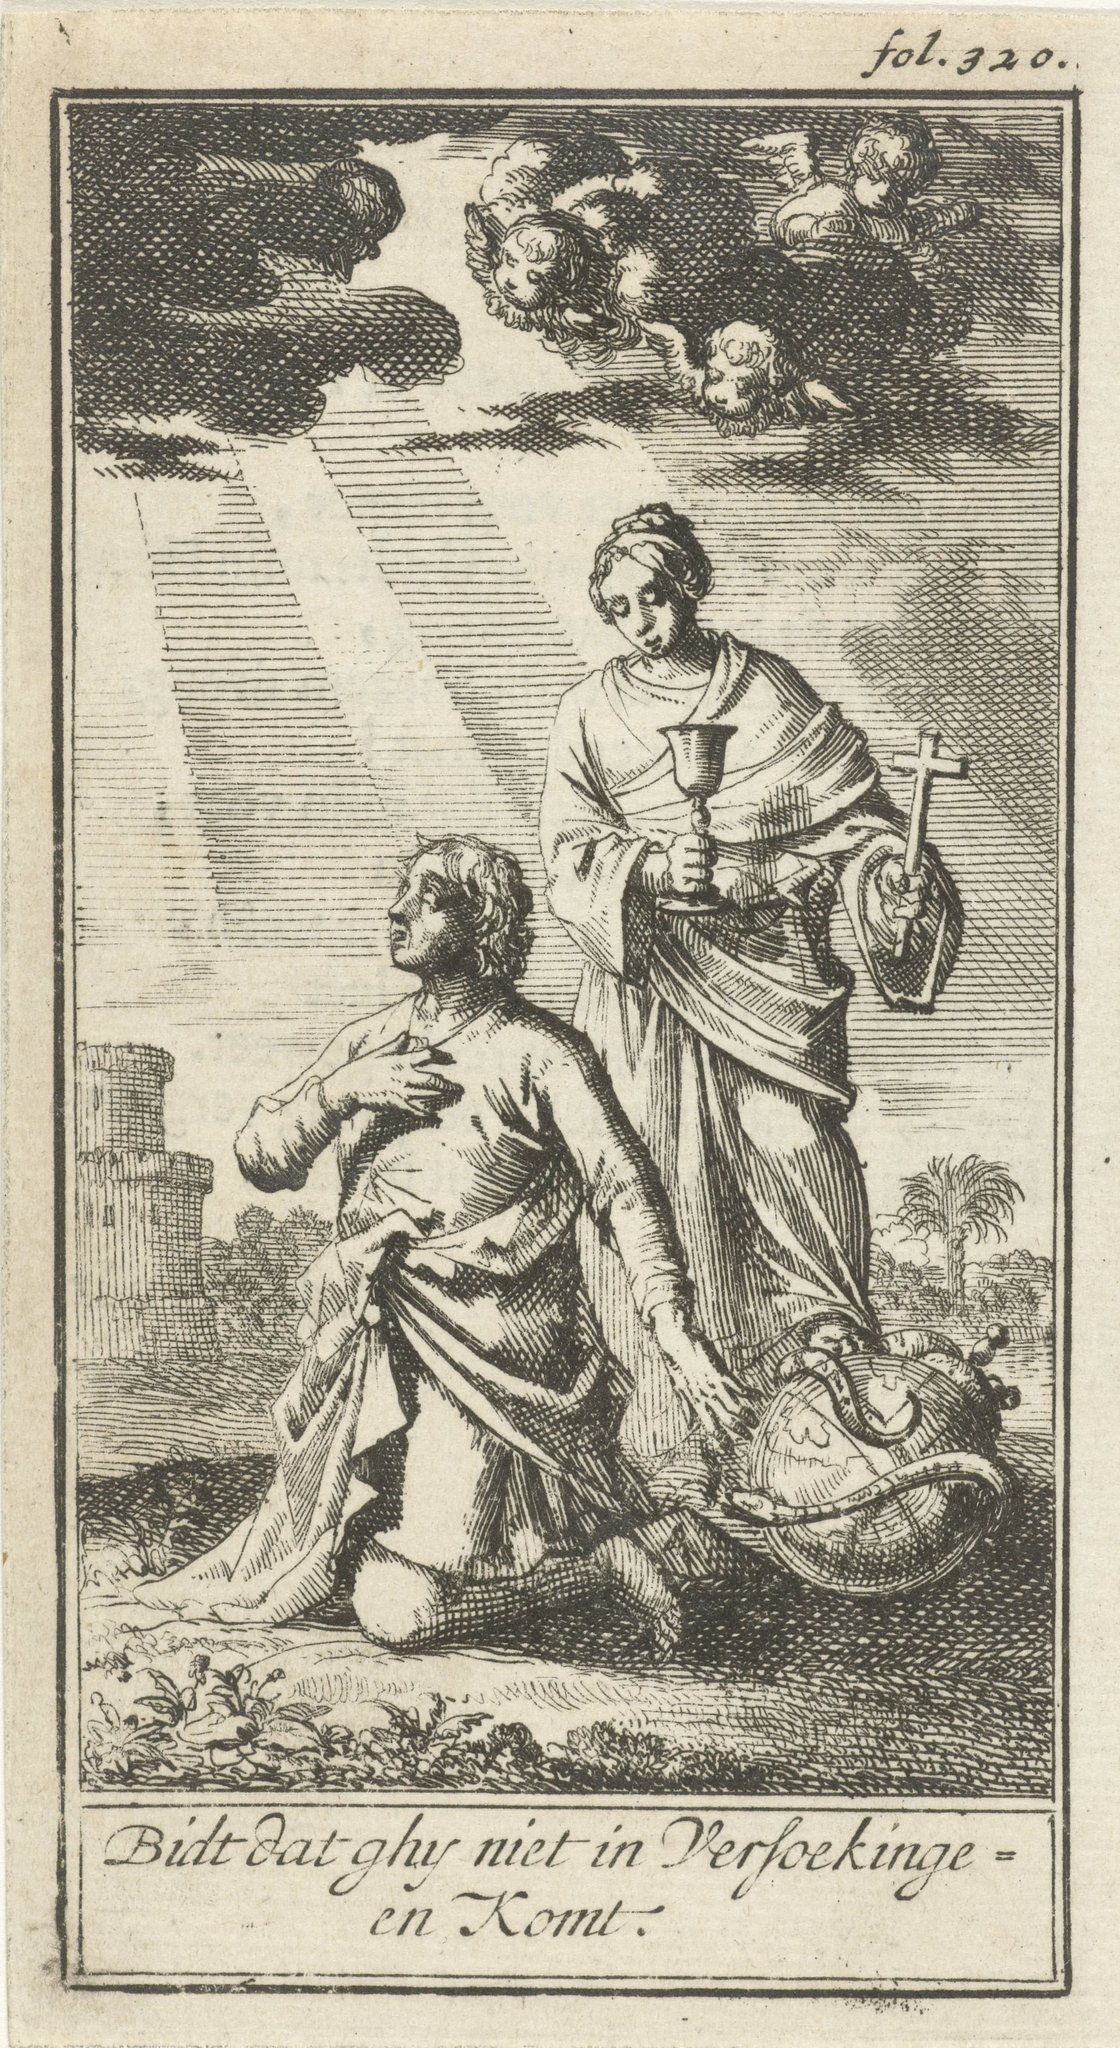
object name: print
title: Bidt dat ghy niet in Versoekinge en Komt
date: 1693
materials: paper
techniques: etching, letterpress printing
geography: rotterdam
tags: fides (faith) as roman personification, one person praying, angels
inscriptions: collector's mark: Lugt 2228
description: Illustratie uit: Molinaeus, Johannes. Sleutel des hemels ofte Christelyk gebede-boek. Amsterdam: Barent Bos, 1693.